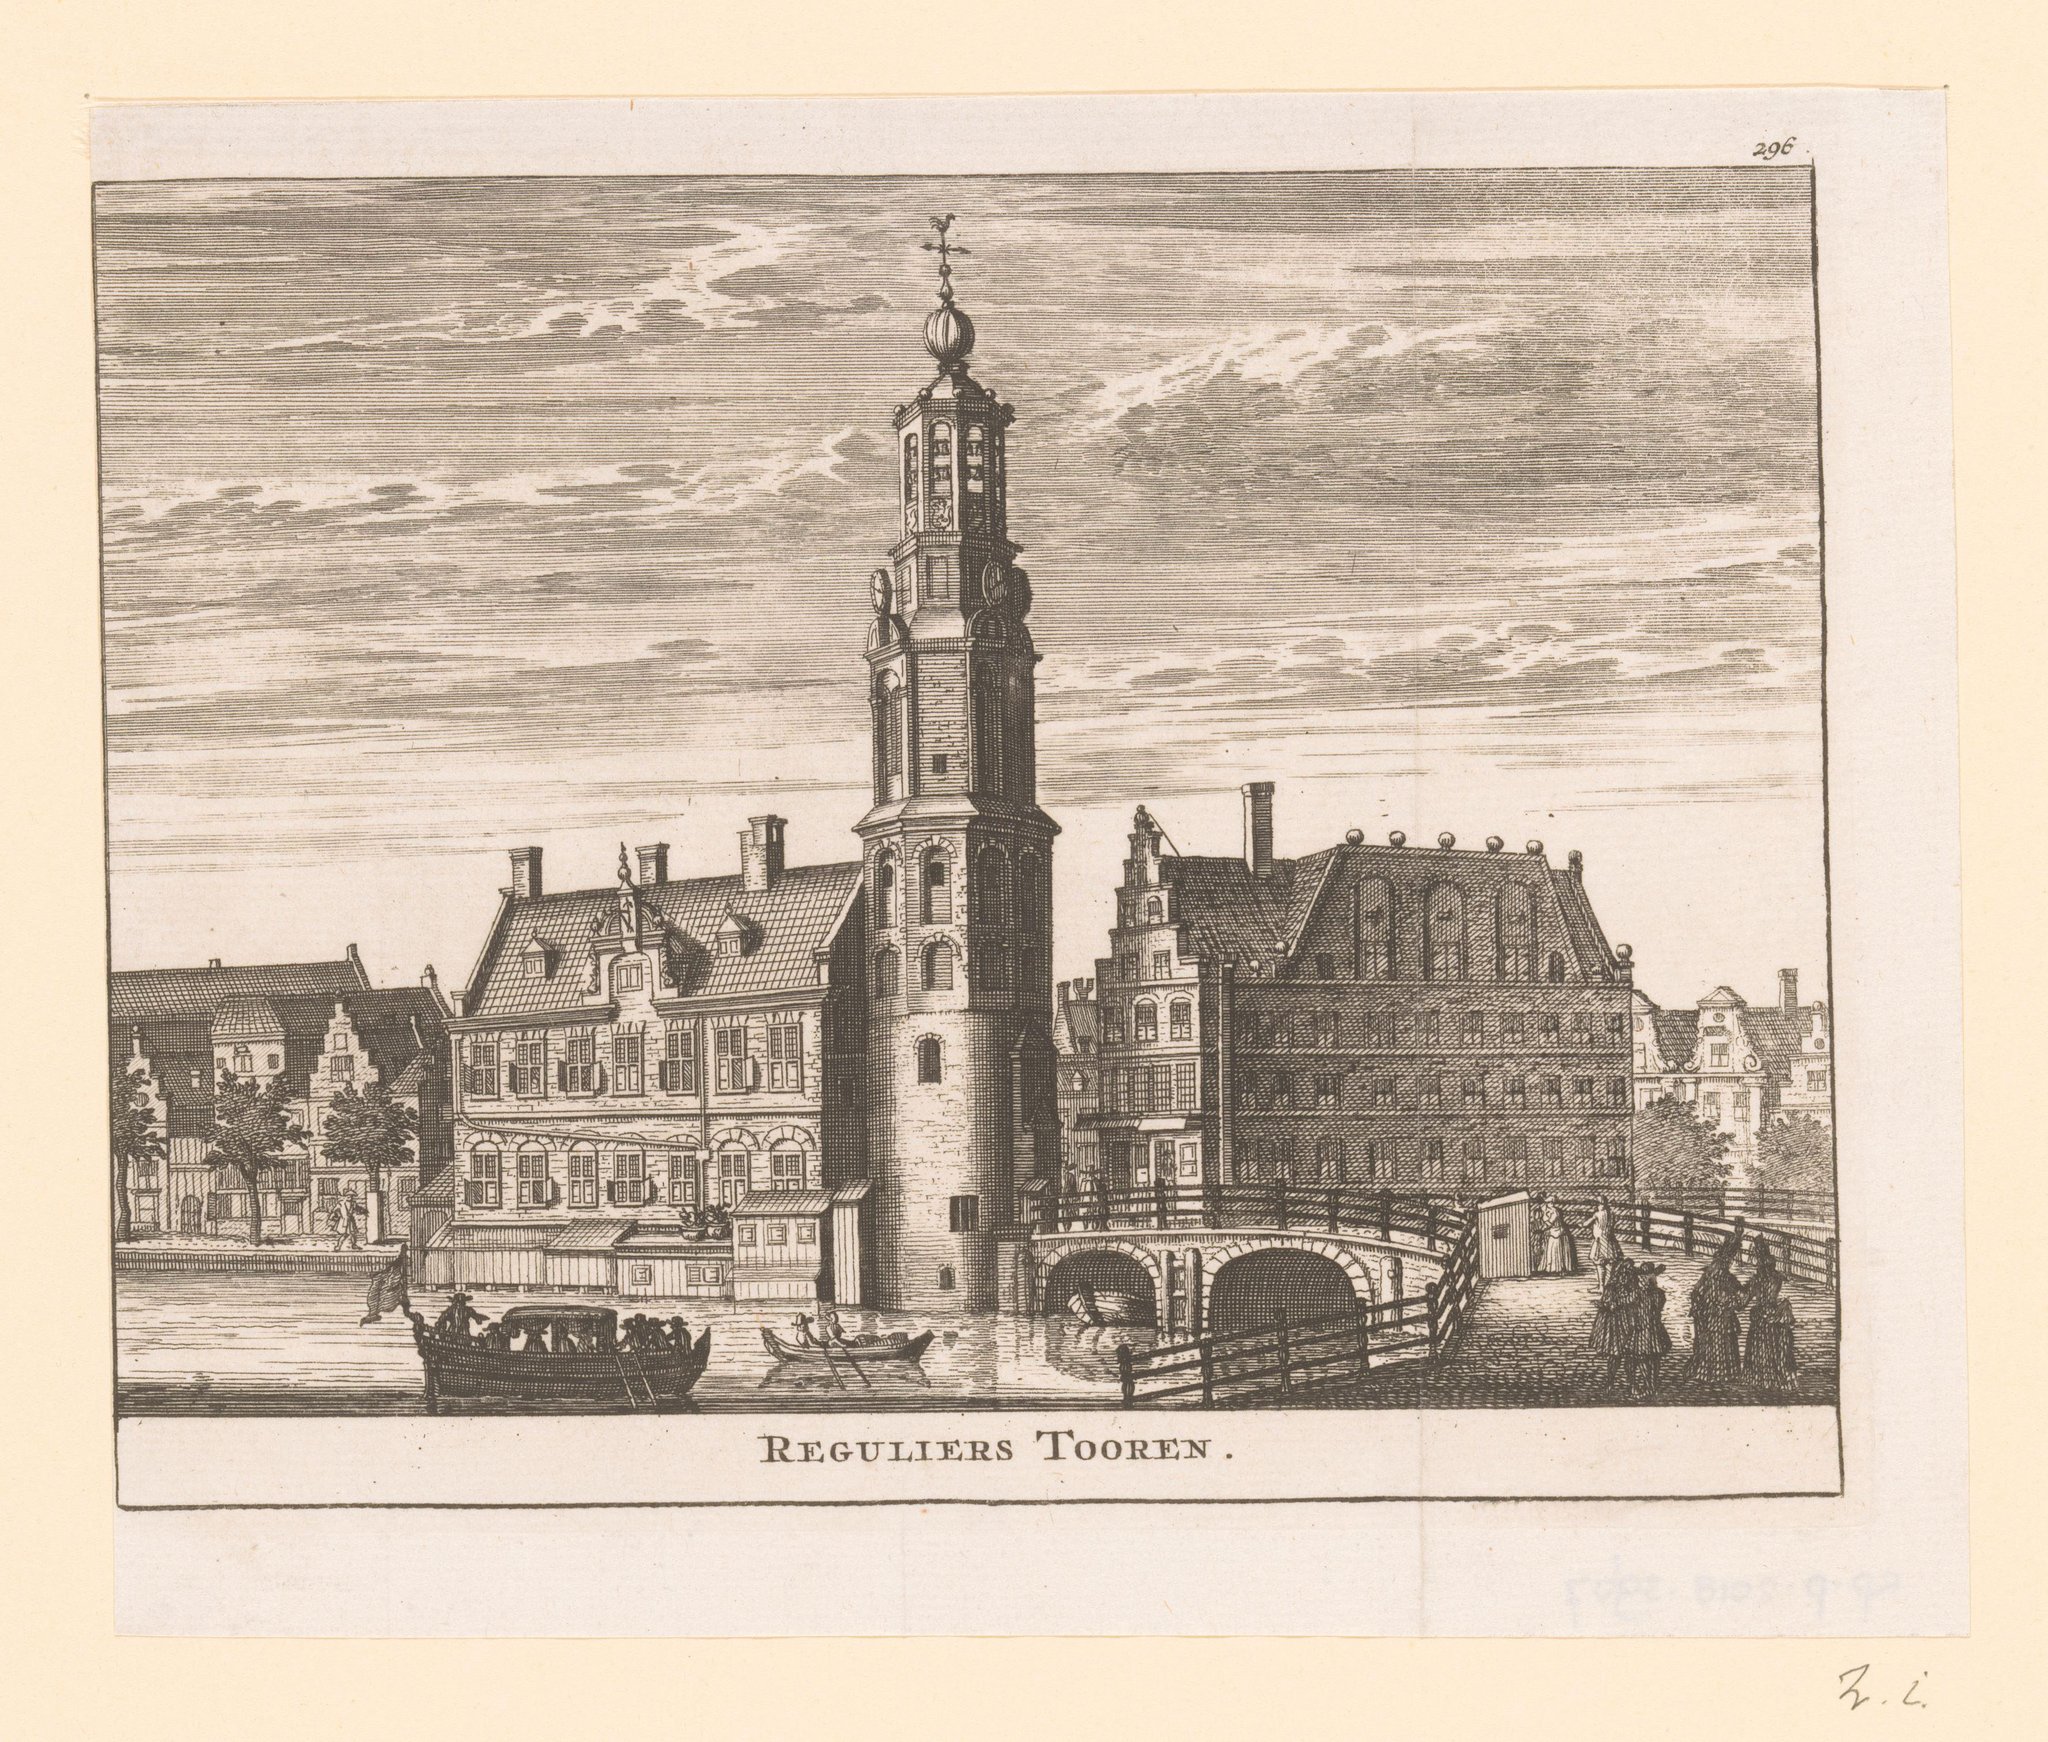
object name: book illustration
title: Reguliers tooren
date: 1726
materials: paper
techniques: etching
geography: amsterdam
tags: tower, clock tower ~ monumental adornment, rowing-boat, canoe, etc., bridge in city across river, canal, etc.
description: Prent uit: Hoorn, Nicolaas ten. Wegwyzer door Amsterdam, Zynde eene beknopte verhandeling van desselfs eerste opkomst, vergrootingen, en teegenwoordigen staat (…). Tweede druk. Amsterdam: Nicolaas ten Hoorn, 1726, p. 296-297. En in de latere edities (Amsterdam: erven J. Ratelband & Co, 1737, en Amsterdam: Pieter Meyer, 1751). In de eerste editie heeft deze prent een andere plek in het boek, en een ander nummer.